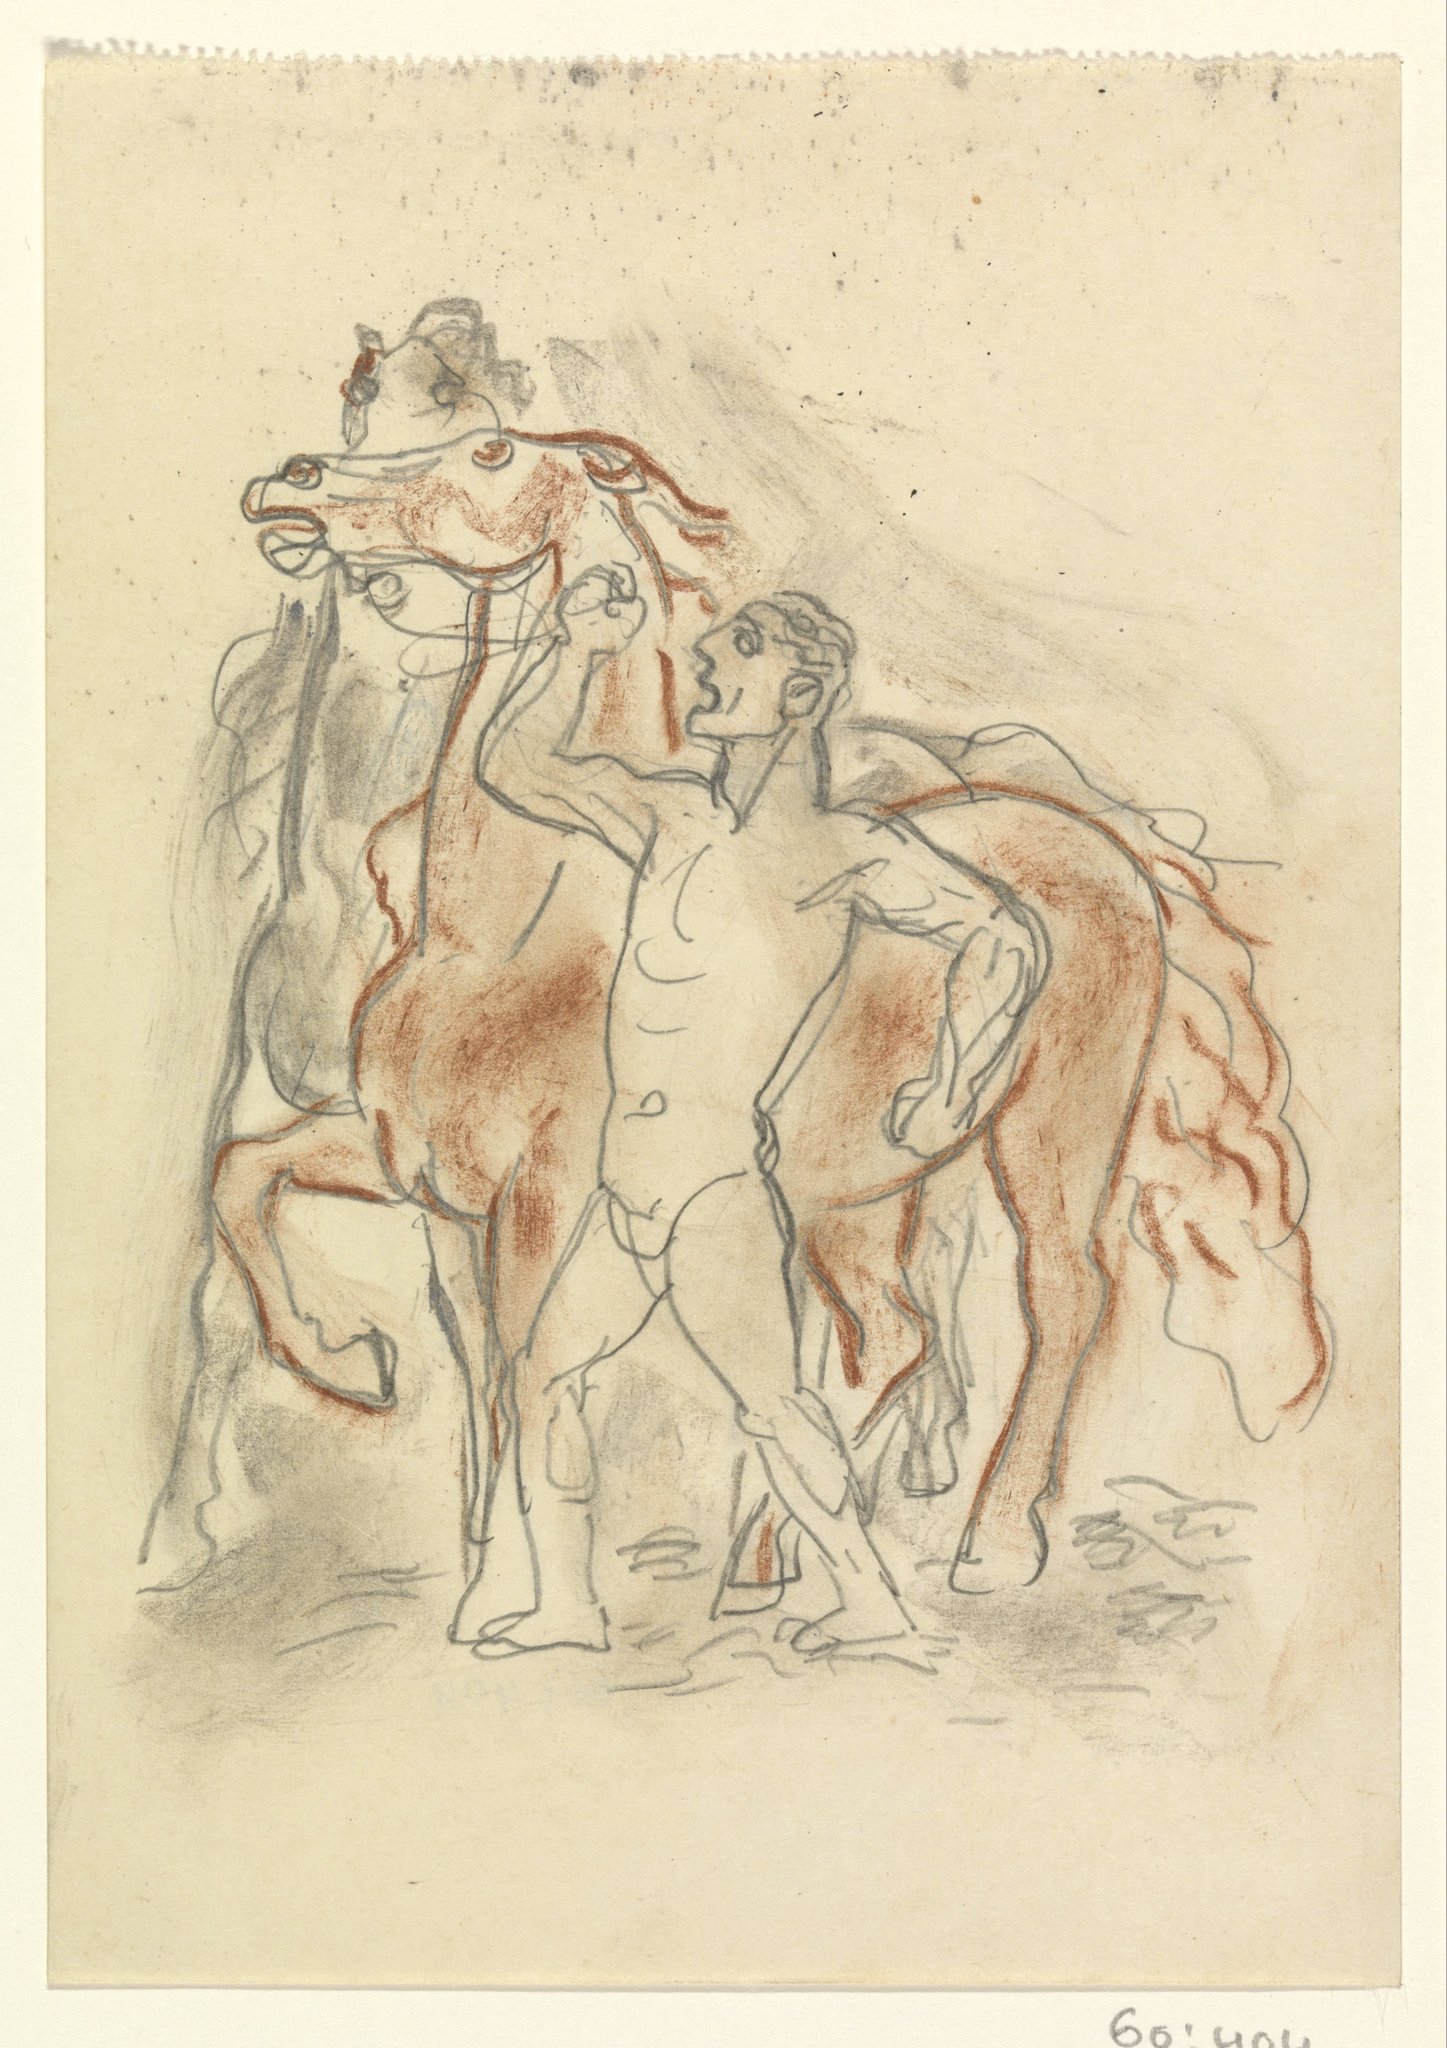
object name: drawing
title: Naakte man houdt twee paarden in bedwang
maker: leo gestel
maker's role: draughtsman, print maker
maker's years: 1881-1941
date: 1891-1941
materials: chalk, paper, pencil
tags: standing figure (+ nude human being), horse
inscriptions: collector's mark: Lugt 2228